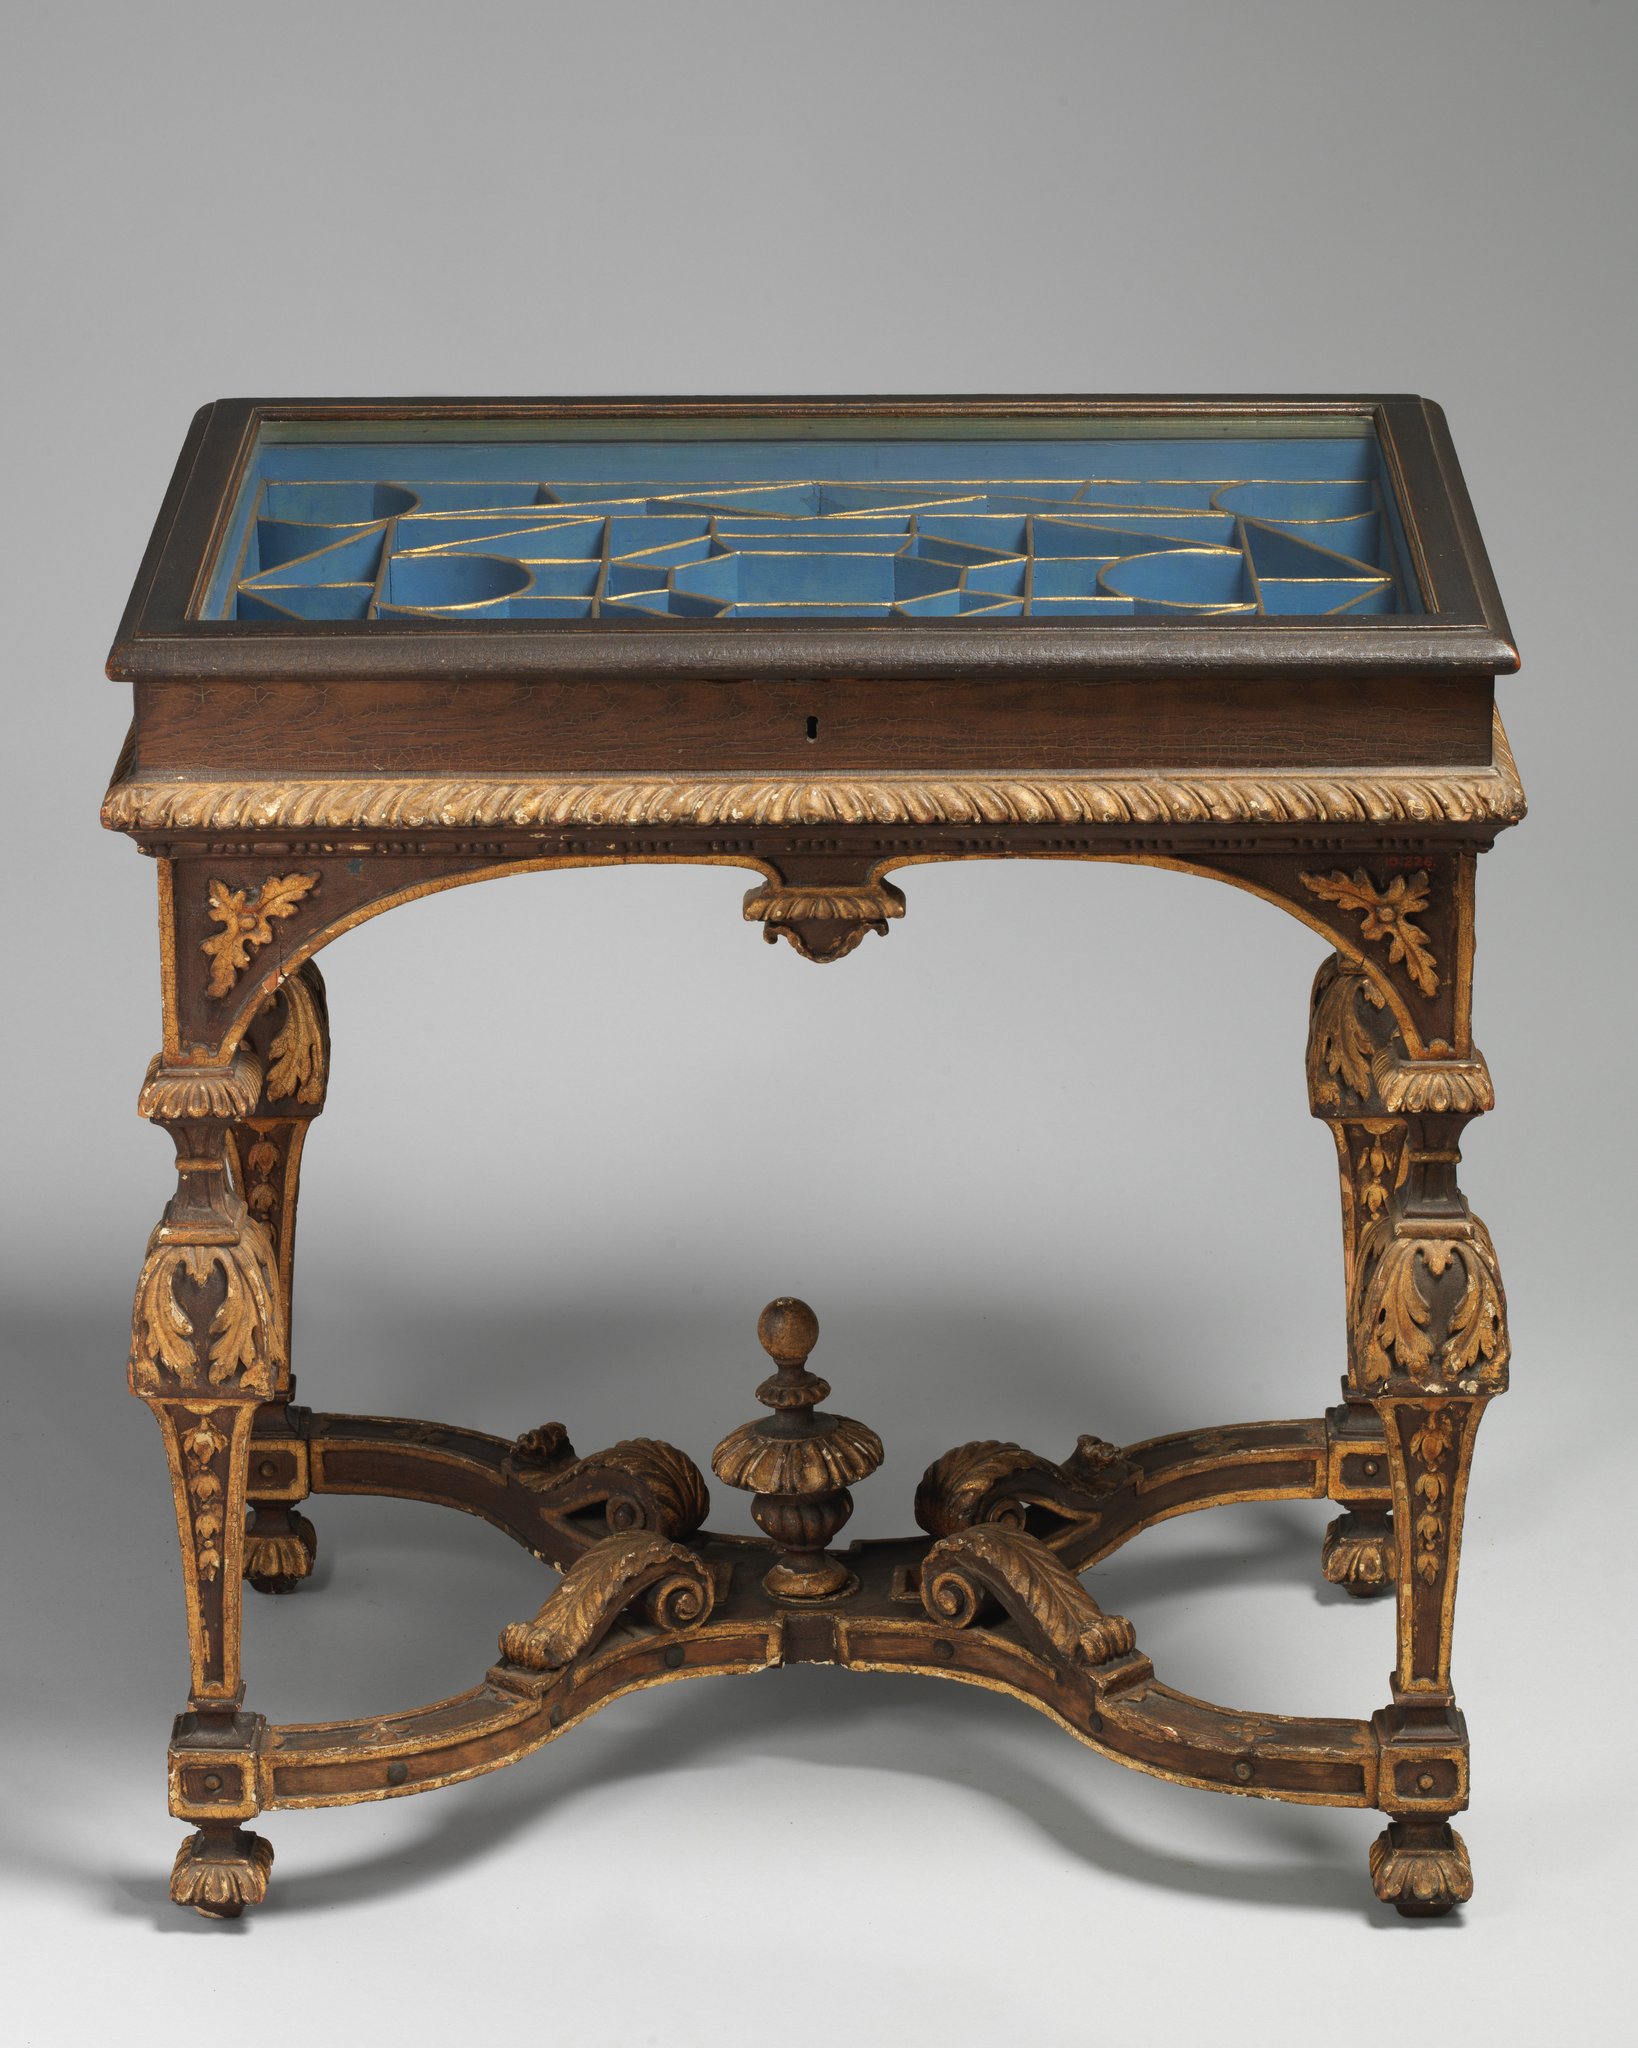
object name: display table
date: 1689-1702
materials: wood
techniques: gilding, painting